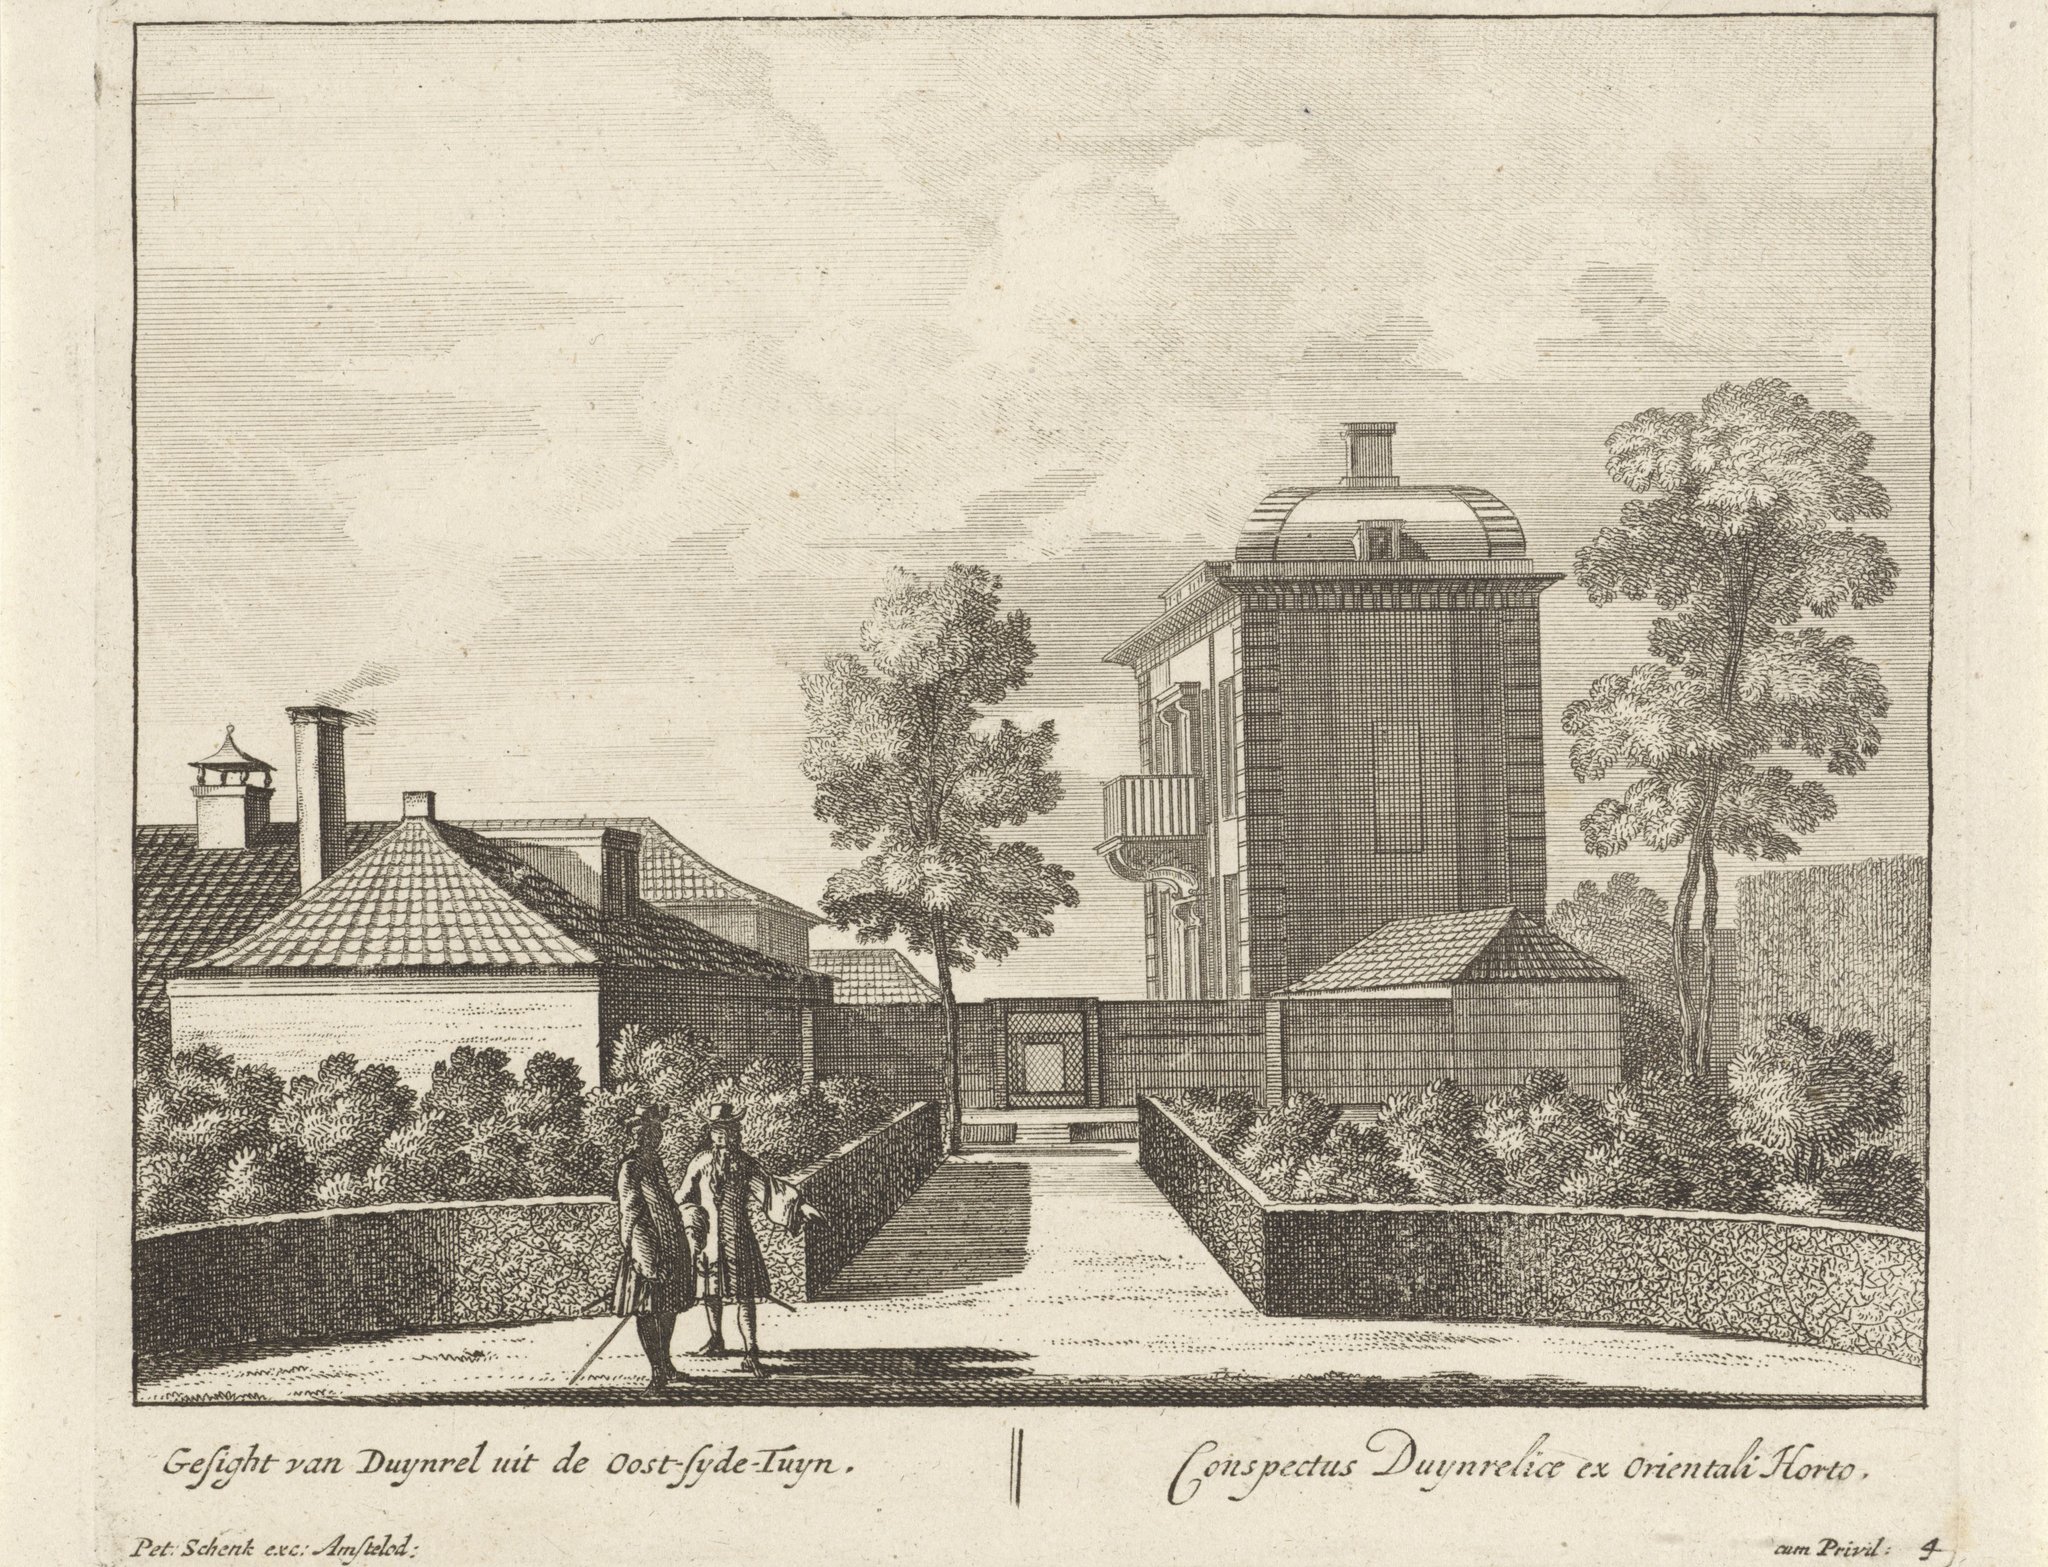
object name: print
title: Gezicht op het oostelijke deel van de tuin en het huis van buitenplaats Duinrell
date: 1675-1711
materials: paper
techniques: engraving, etching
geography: amsterdam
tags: french or architectonic garden; formal garden, country-house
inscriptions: collector's mark: Lugt 2228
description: Gezicht op het oostelijke deel van de tuin en het huis van buitenplaats Duinrell. In de tuin twee figuren. Rechtsonder genummerd: 4. Prent uit een serie van zestien prenten van Duinrell.